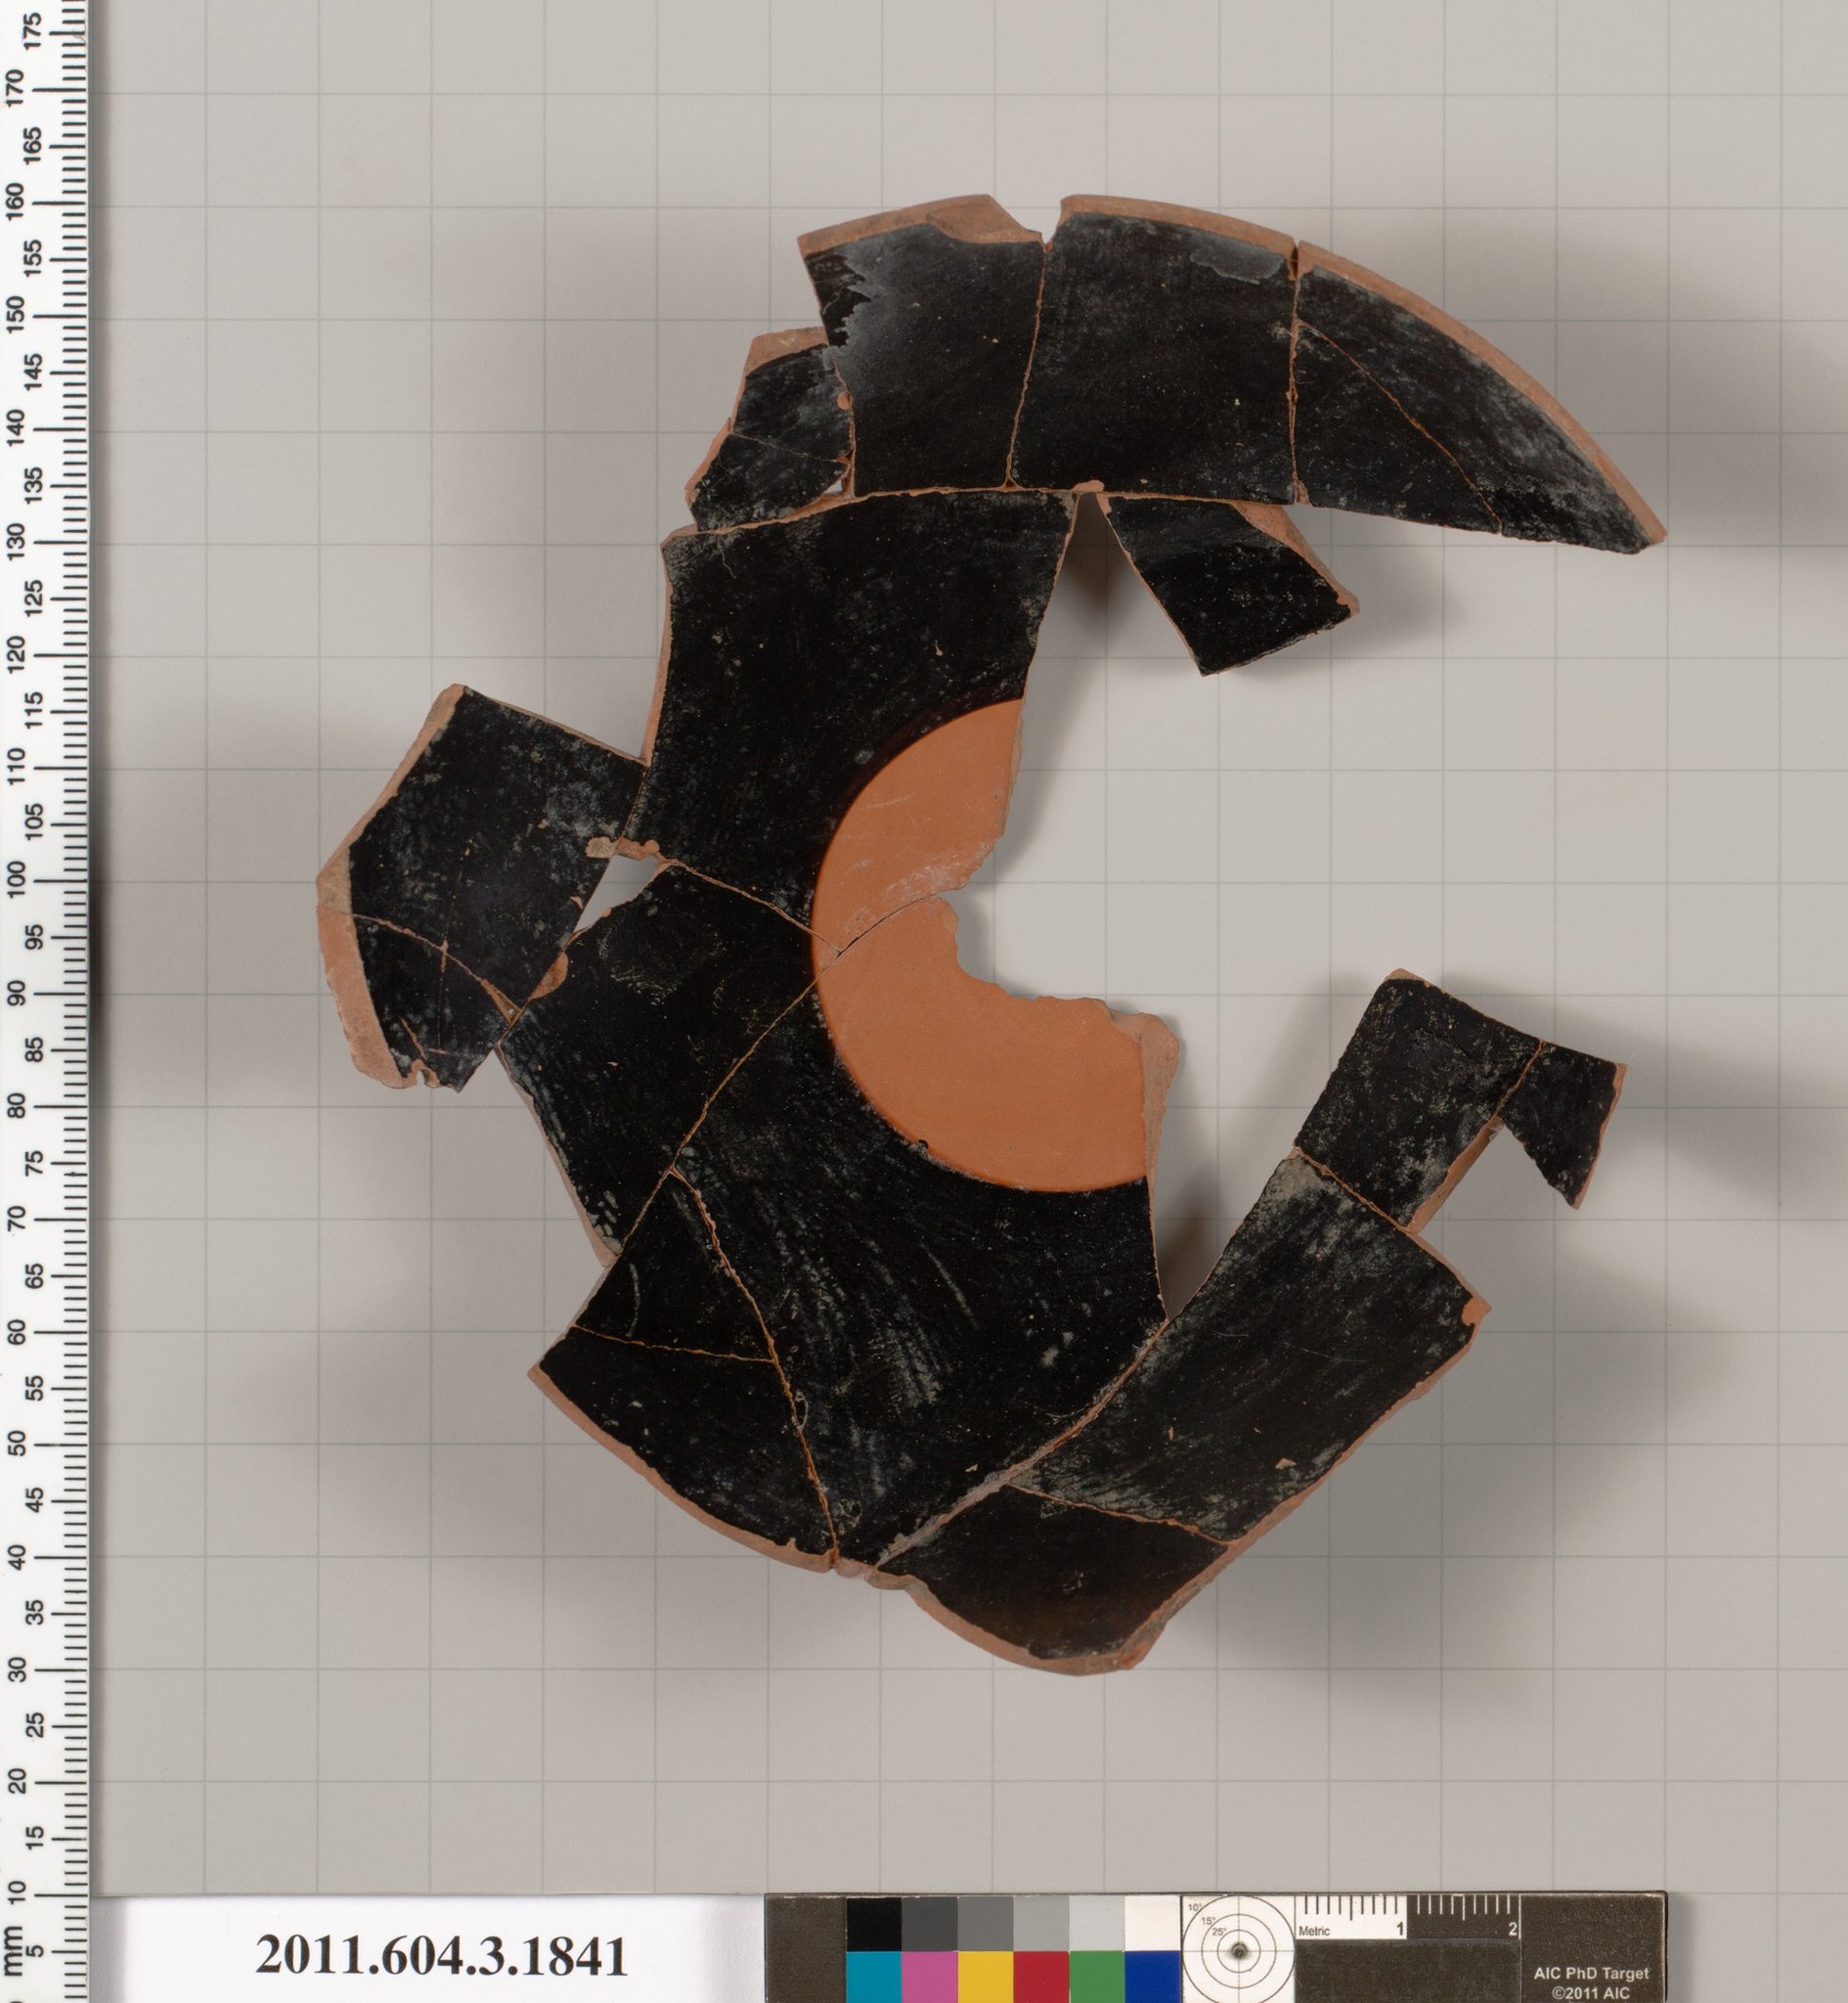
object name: kylix fragment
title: Terracotta fragment of a kylix: Lip cup (drinking cup)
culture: greek, attic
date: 560-550 BCE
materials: terracotta